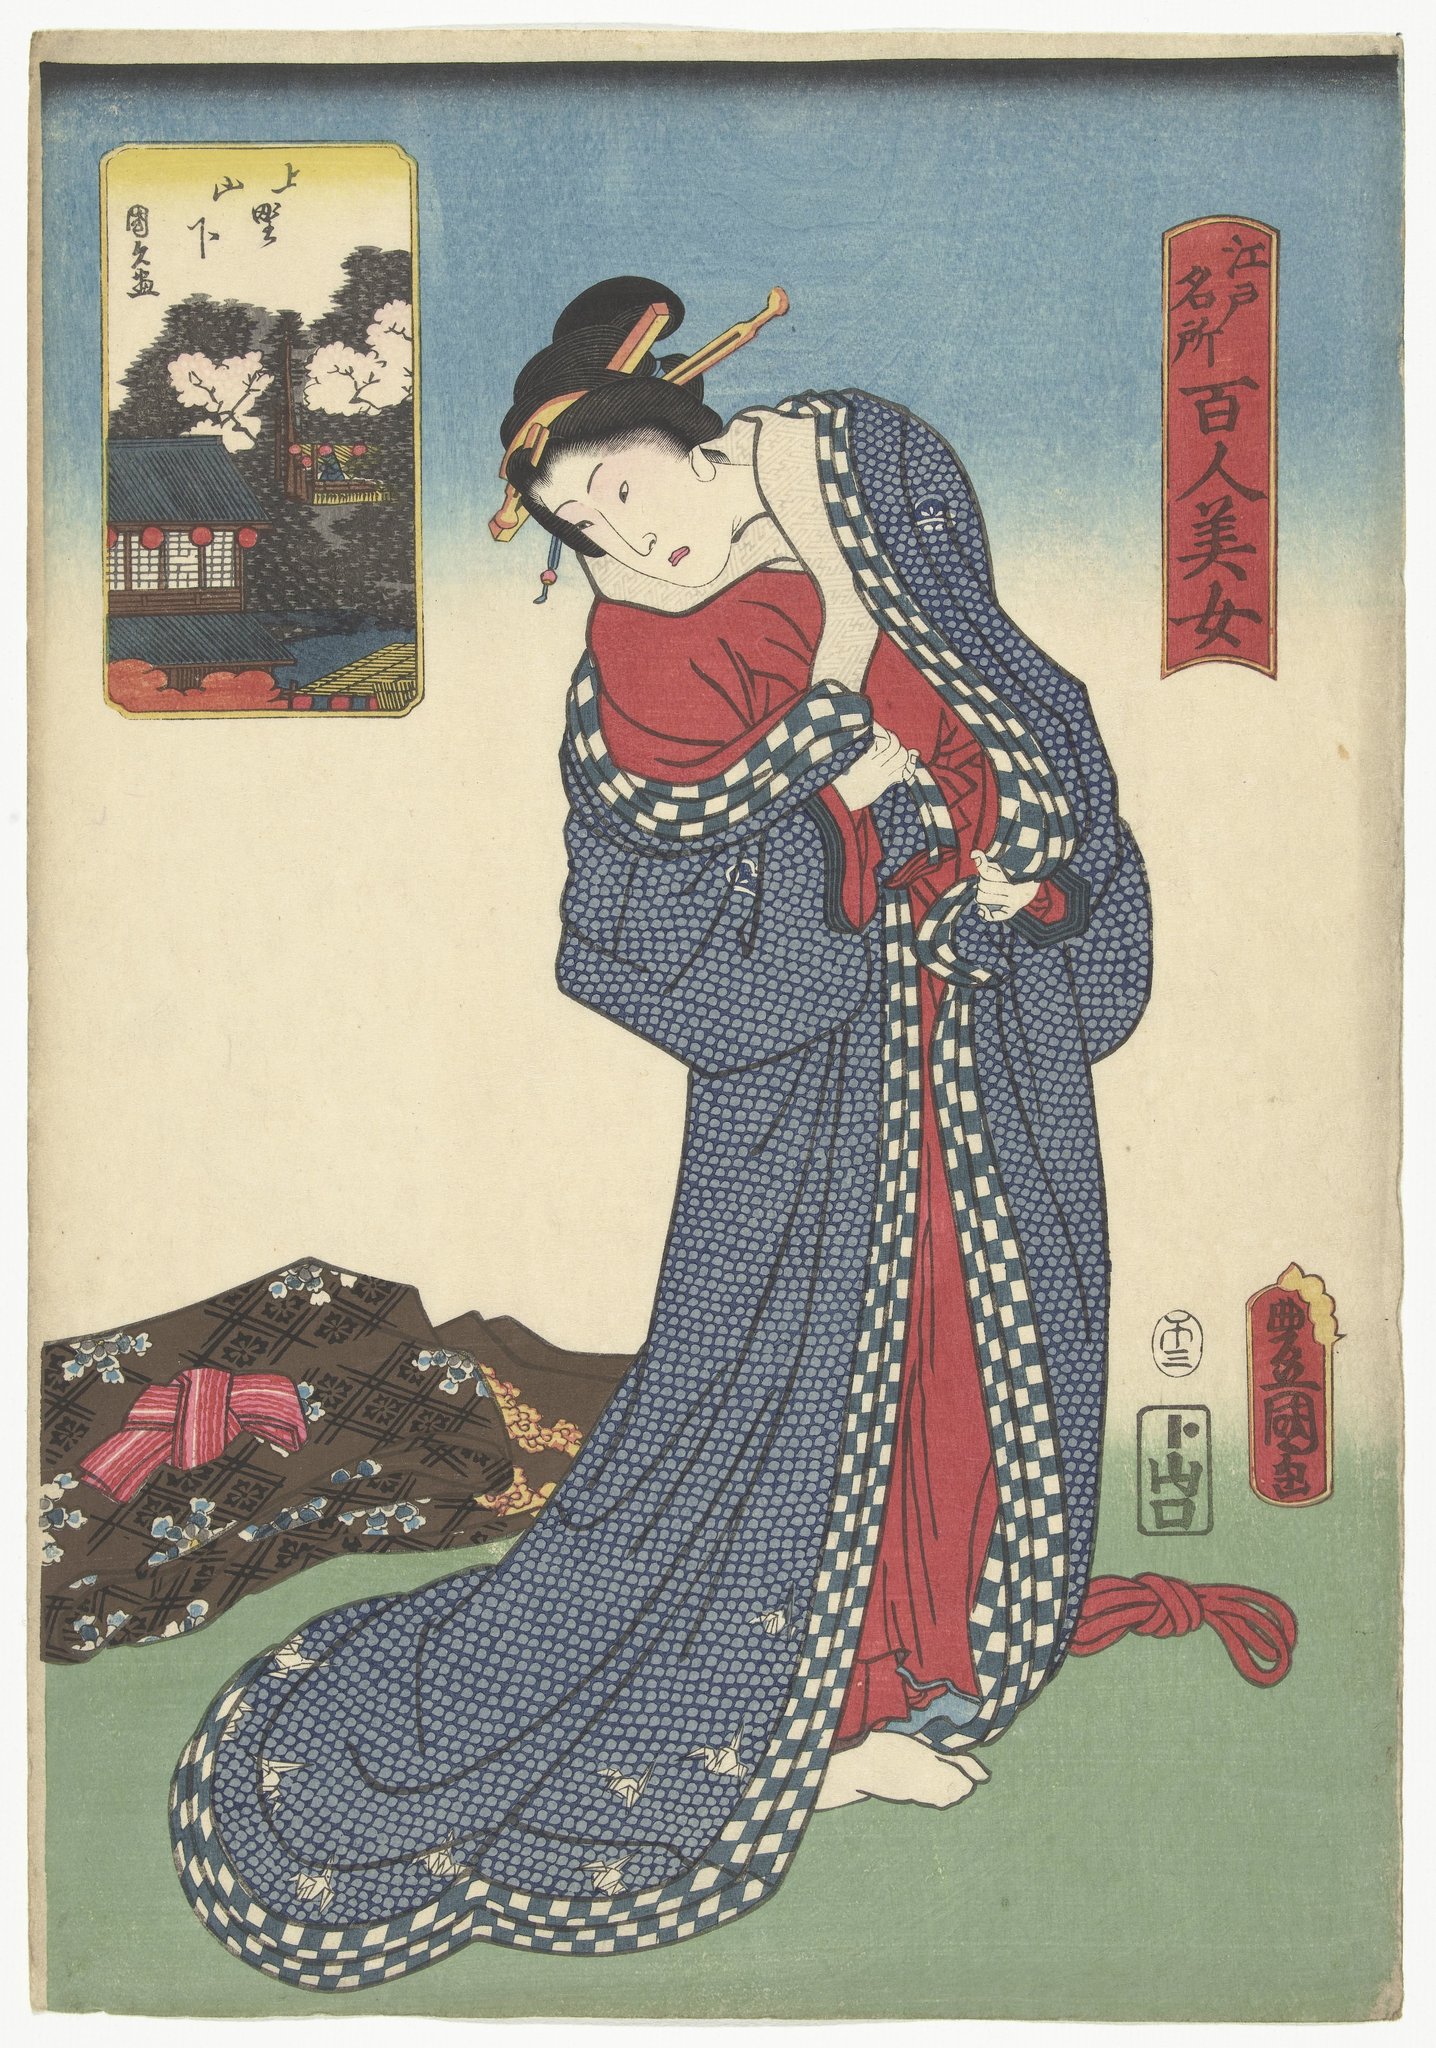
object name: print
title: Edo meisho hyakunin bijo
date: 1803-1858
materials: paper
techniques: woodcut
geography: japan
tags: adult woman, looking downwards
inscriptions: date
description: Vrouw, ten voeten uit, gekleed in blauwe en rode kimono en witte sokken, kijkend naar haar blauw-wit geblokte kimonorand waarboven een origami kraanvogelmotief zichtbaar. Linksboven een rechthoekig cartouche met gezicht op theehuis en roze bloesembomen.